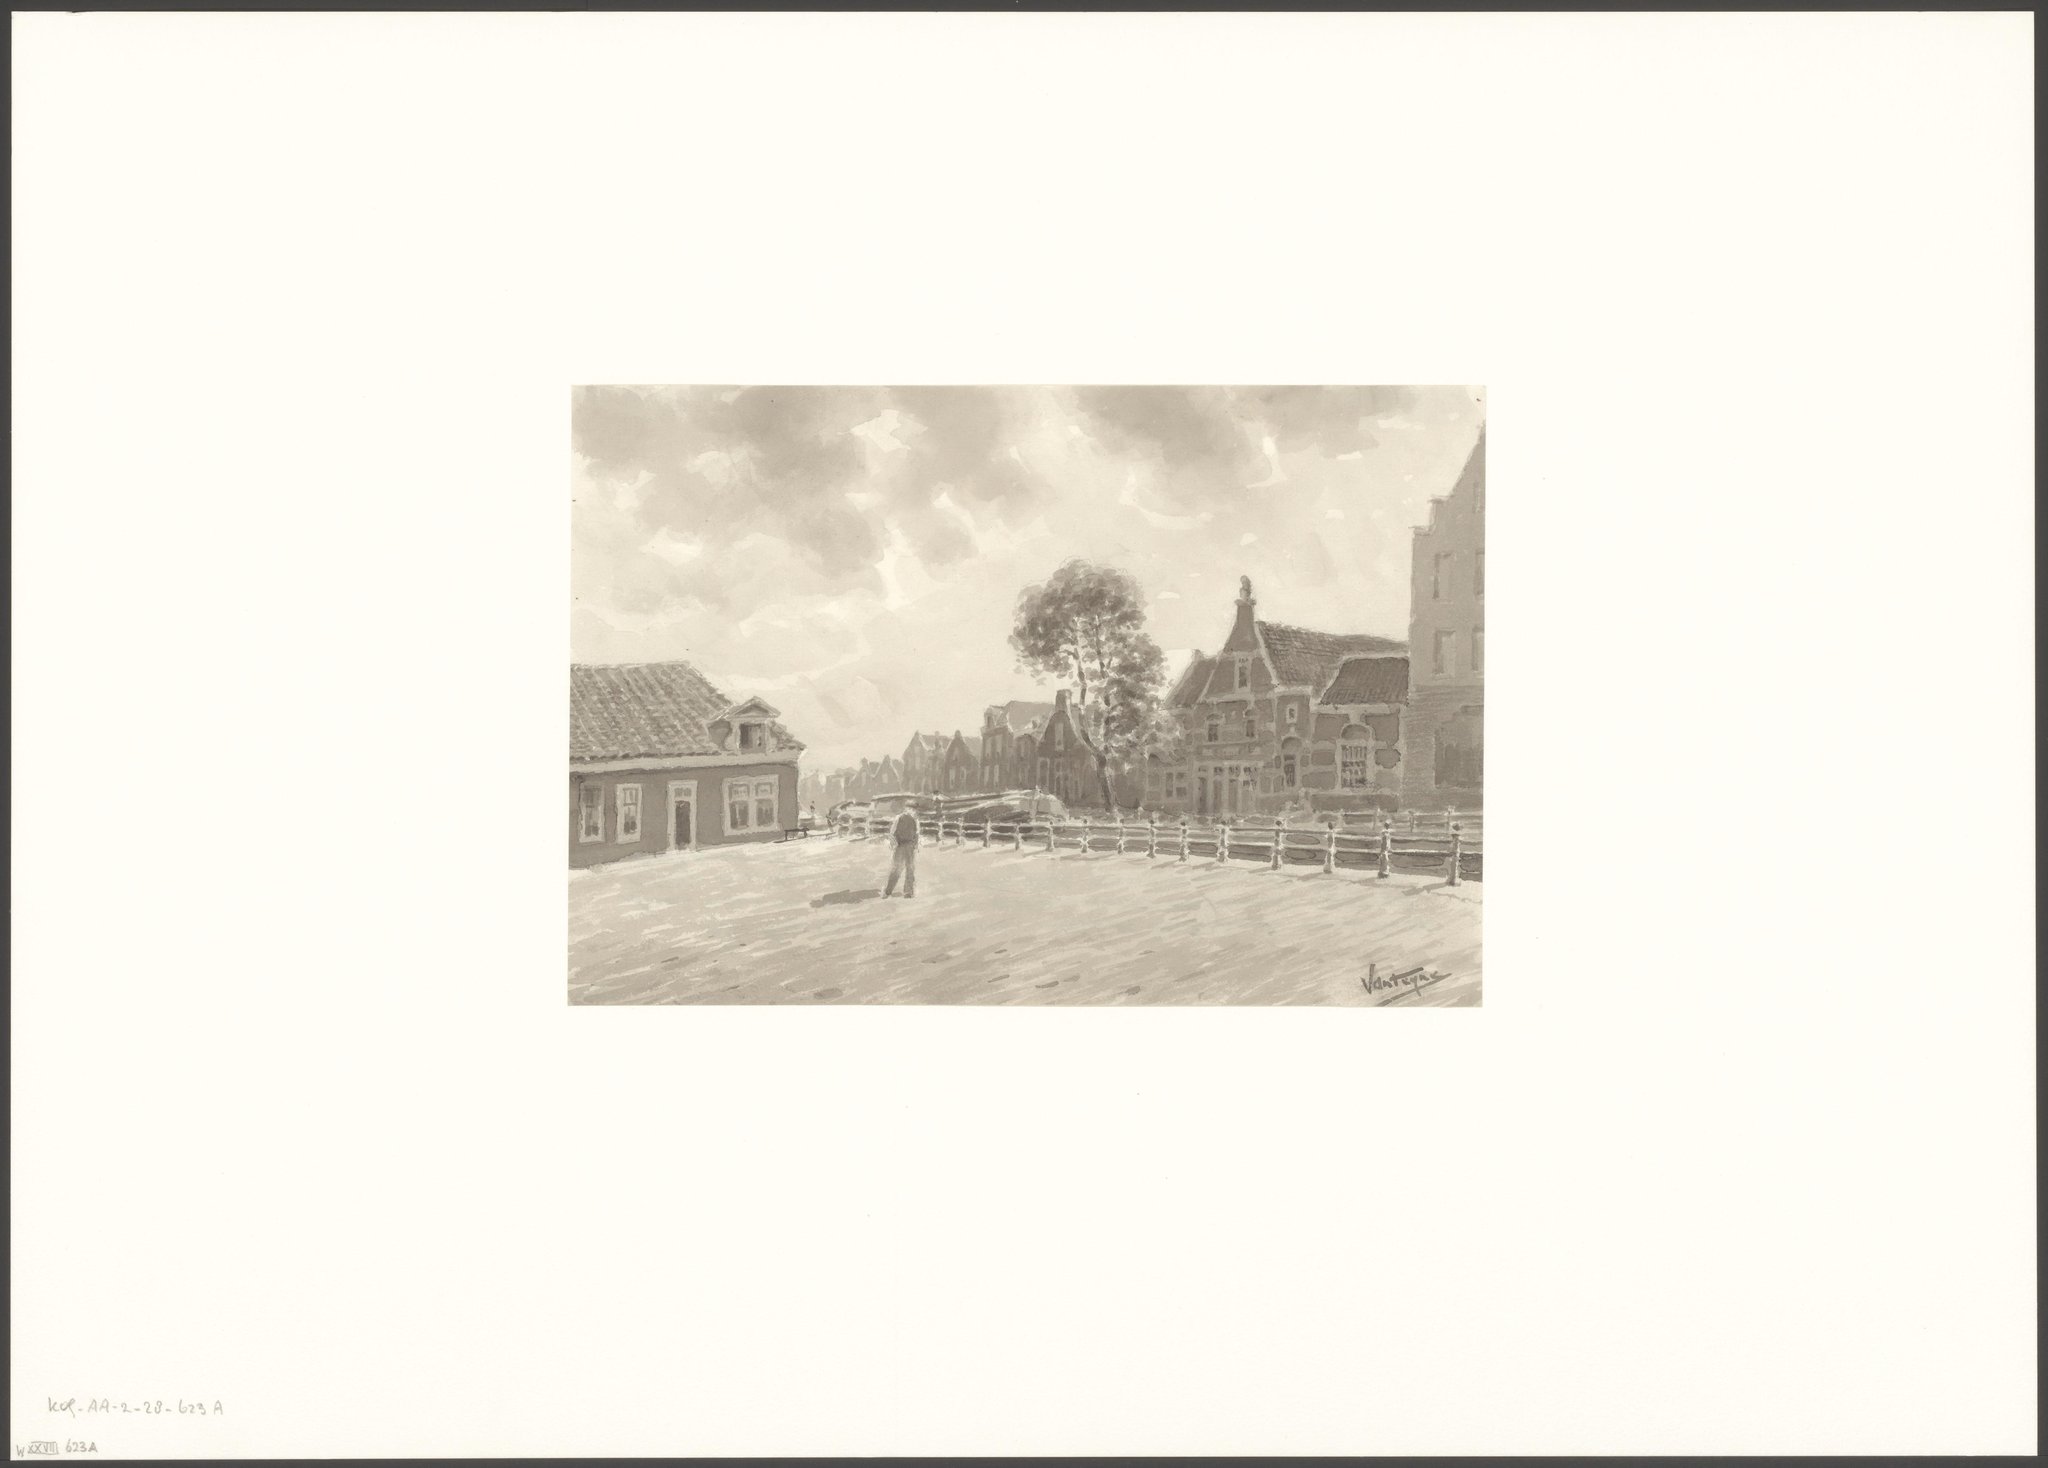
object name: drawing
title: Gezicht op de Overtoom, gezien naar de Sloterkade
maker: anthonie van teijn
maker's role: draughtsman, painter, print maker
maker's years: 1863-1943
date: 1910-1927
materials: ink, paper, pencil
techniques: brush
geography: amsterdam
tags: city-view in general; 'veduta', canal, street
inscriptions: inscription: ‘De Overtoomsche Sluis (...) Oct 1927. / vanEck’, signature: ‘VanTeyne’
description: Tekening binnen de Atlas Van Eck ingedeeld op wijknummer 28.